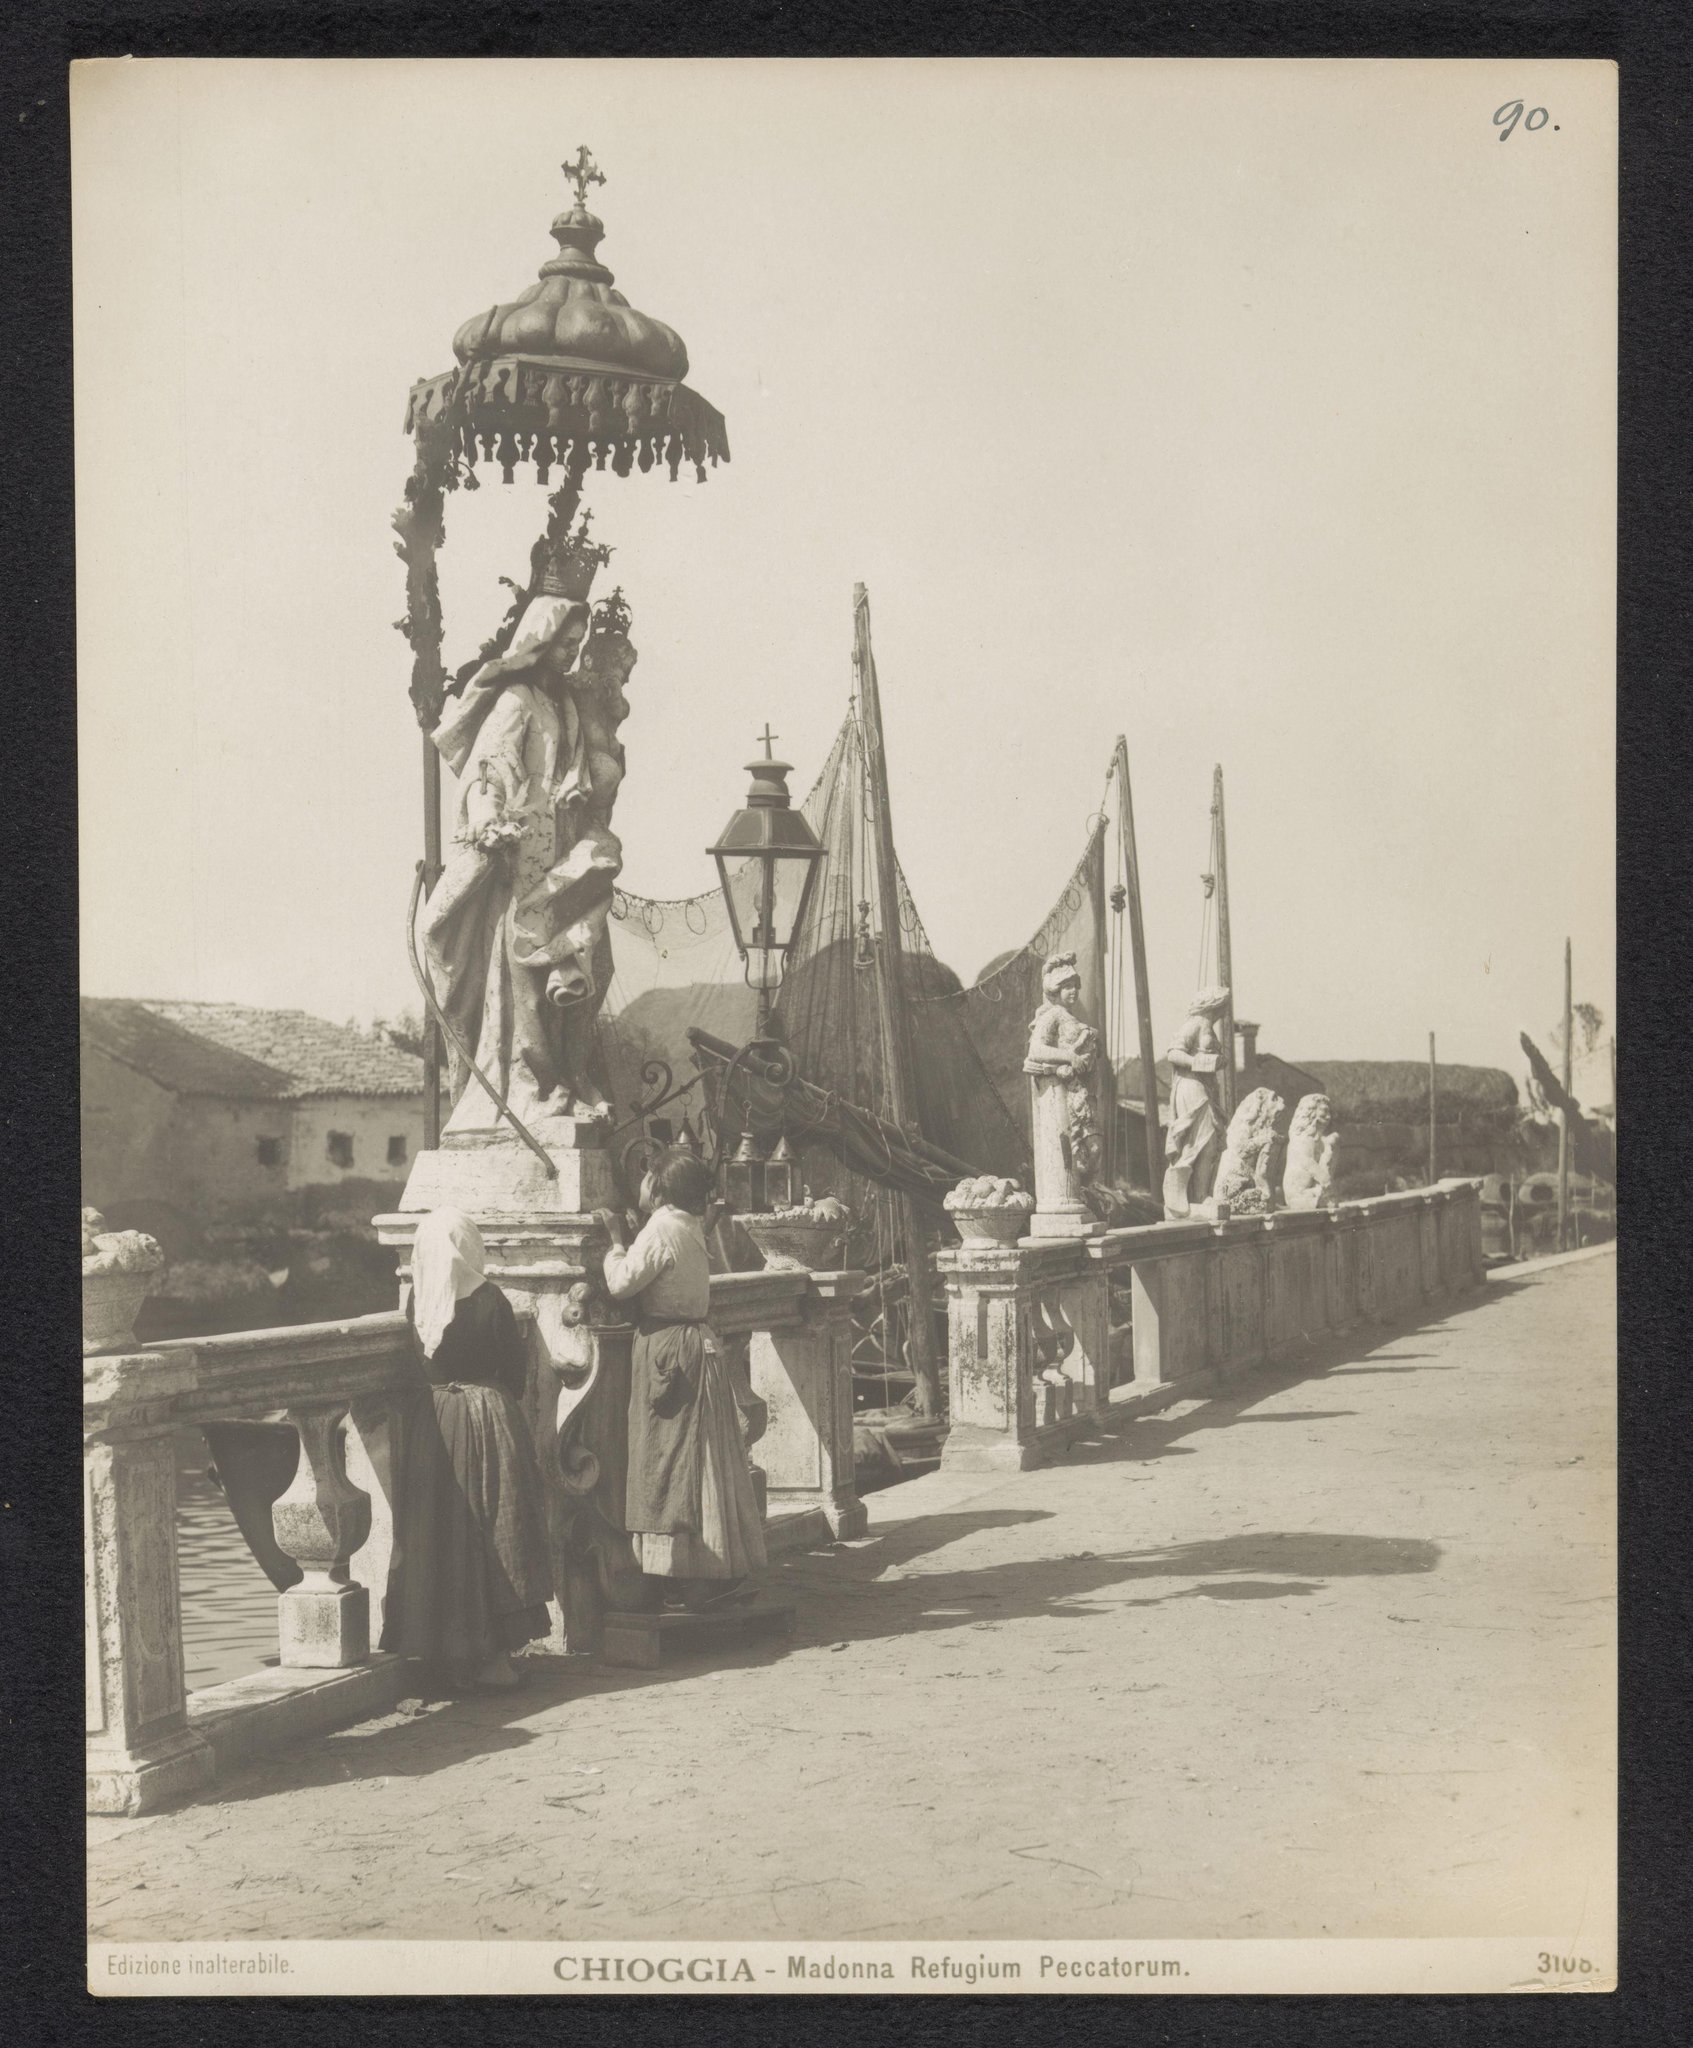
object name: photograph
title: Twee meisjes voor een Madonnabeeld te Chioggia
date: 1900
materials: cardboard, photographic support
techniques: gelatin silver print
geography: chioggia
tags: adolescent, young woman, maiden, madonna: i.e. mary with the christ-child, sculpture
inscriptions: number: ‘3108.’, number: ‘90.’